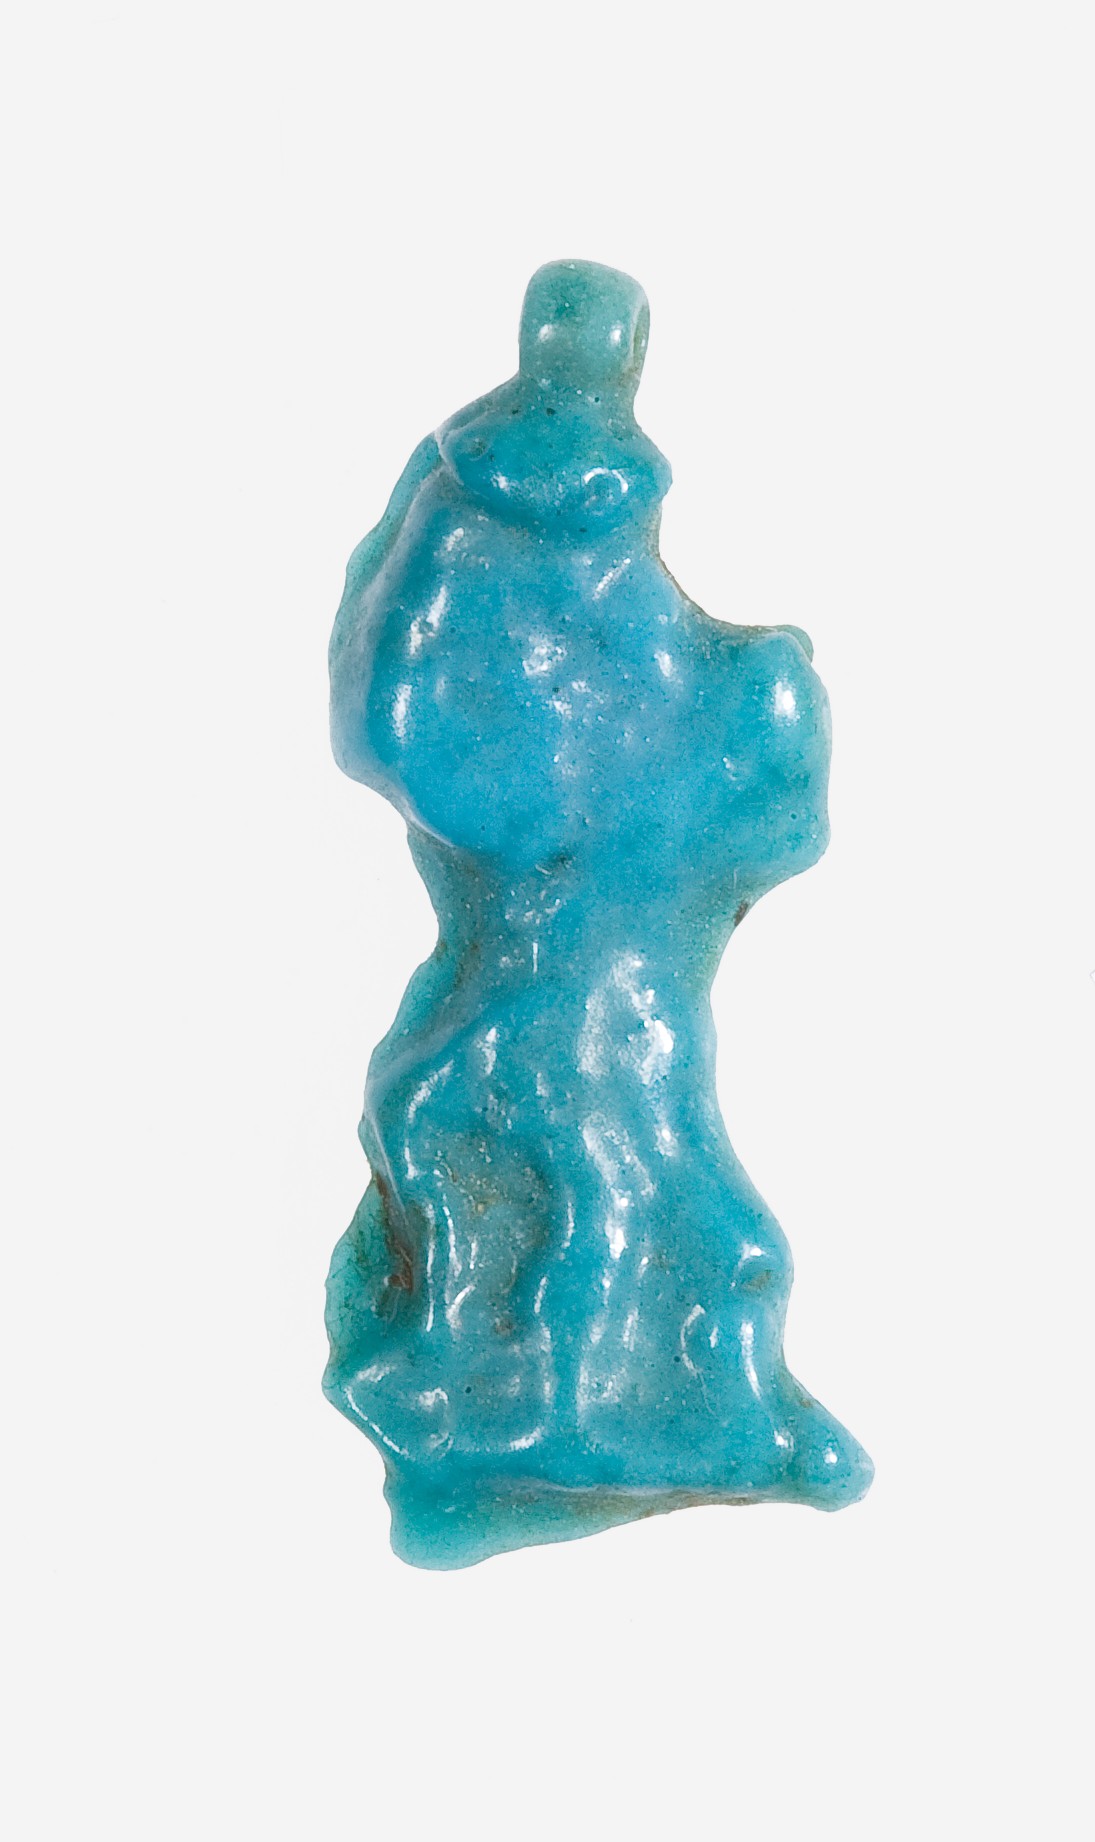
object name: pendant, be, tambourine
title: Amulet: Bes with tambourine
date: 1390-1352 BCE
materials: faience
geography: egypt